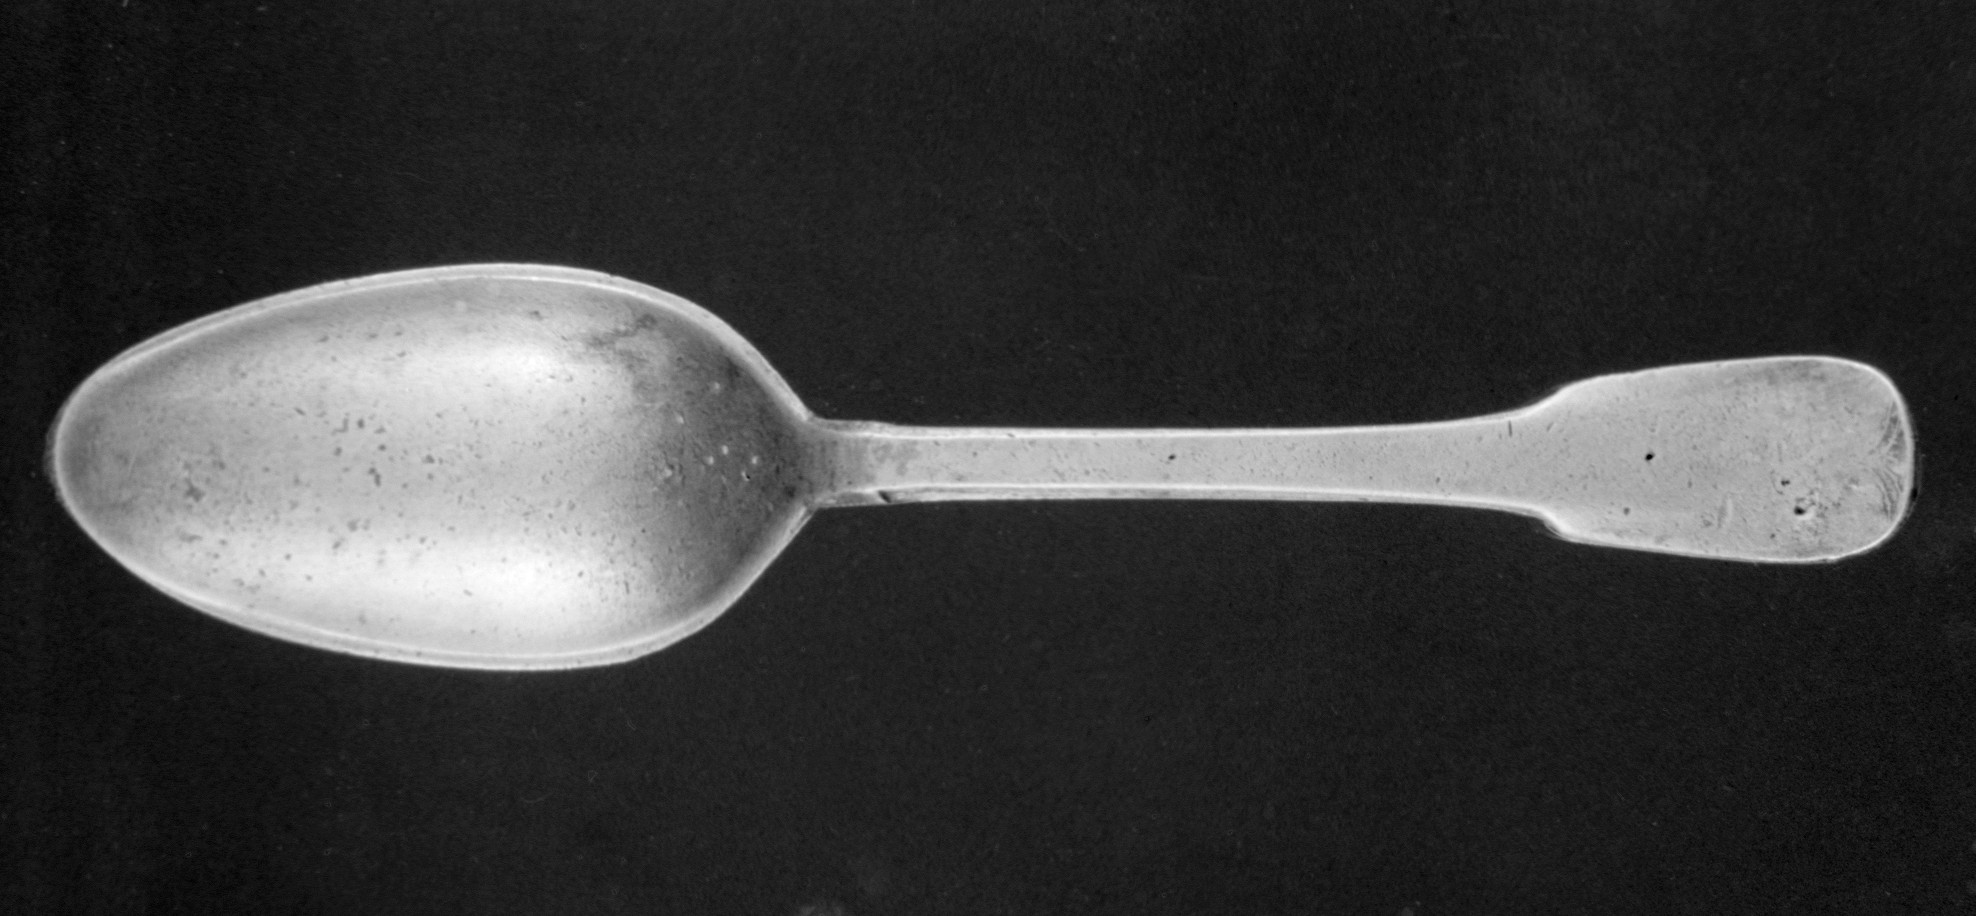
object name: spoon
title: Set of twelve spoons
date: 1701-1800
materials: pewter